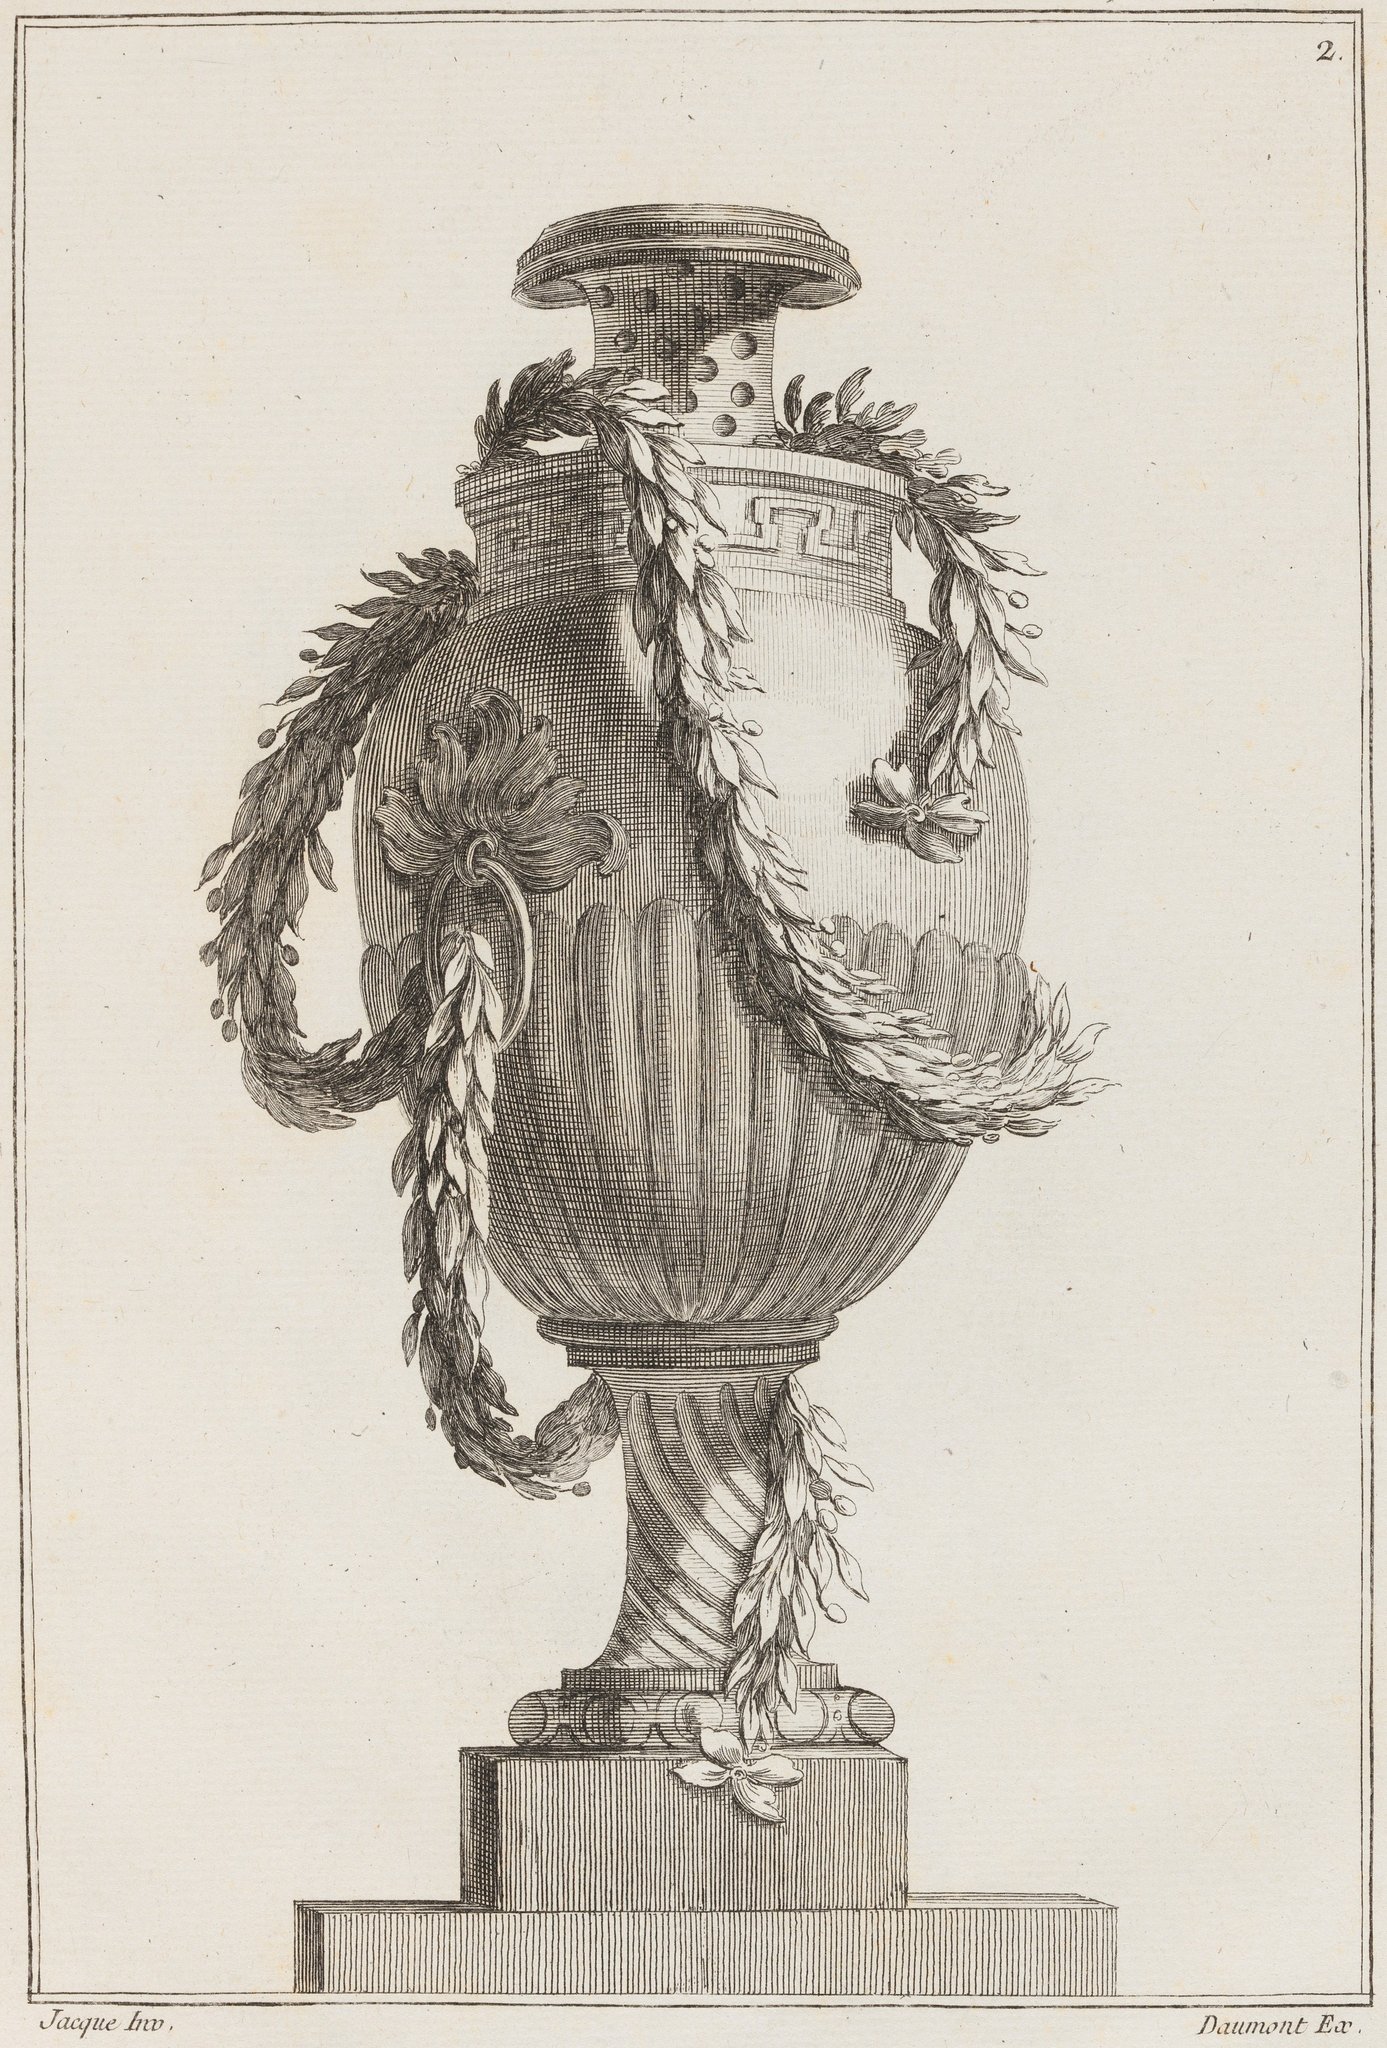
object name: album print ornament architecture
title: Vases Nouveaux Composées par M. Jacque[s]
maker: maurice jacques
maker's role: designer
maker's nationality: french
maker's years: 1712-1784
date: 1701-1800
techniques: etching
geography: france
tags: leaves,vases